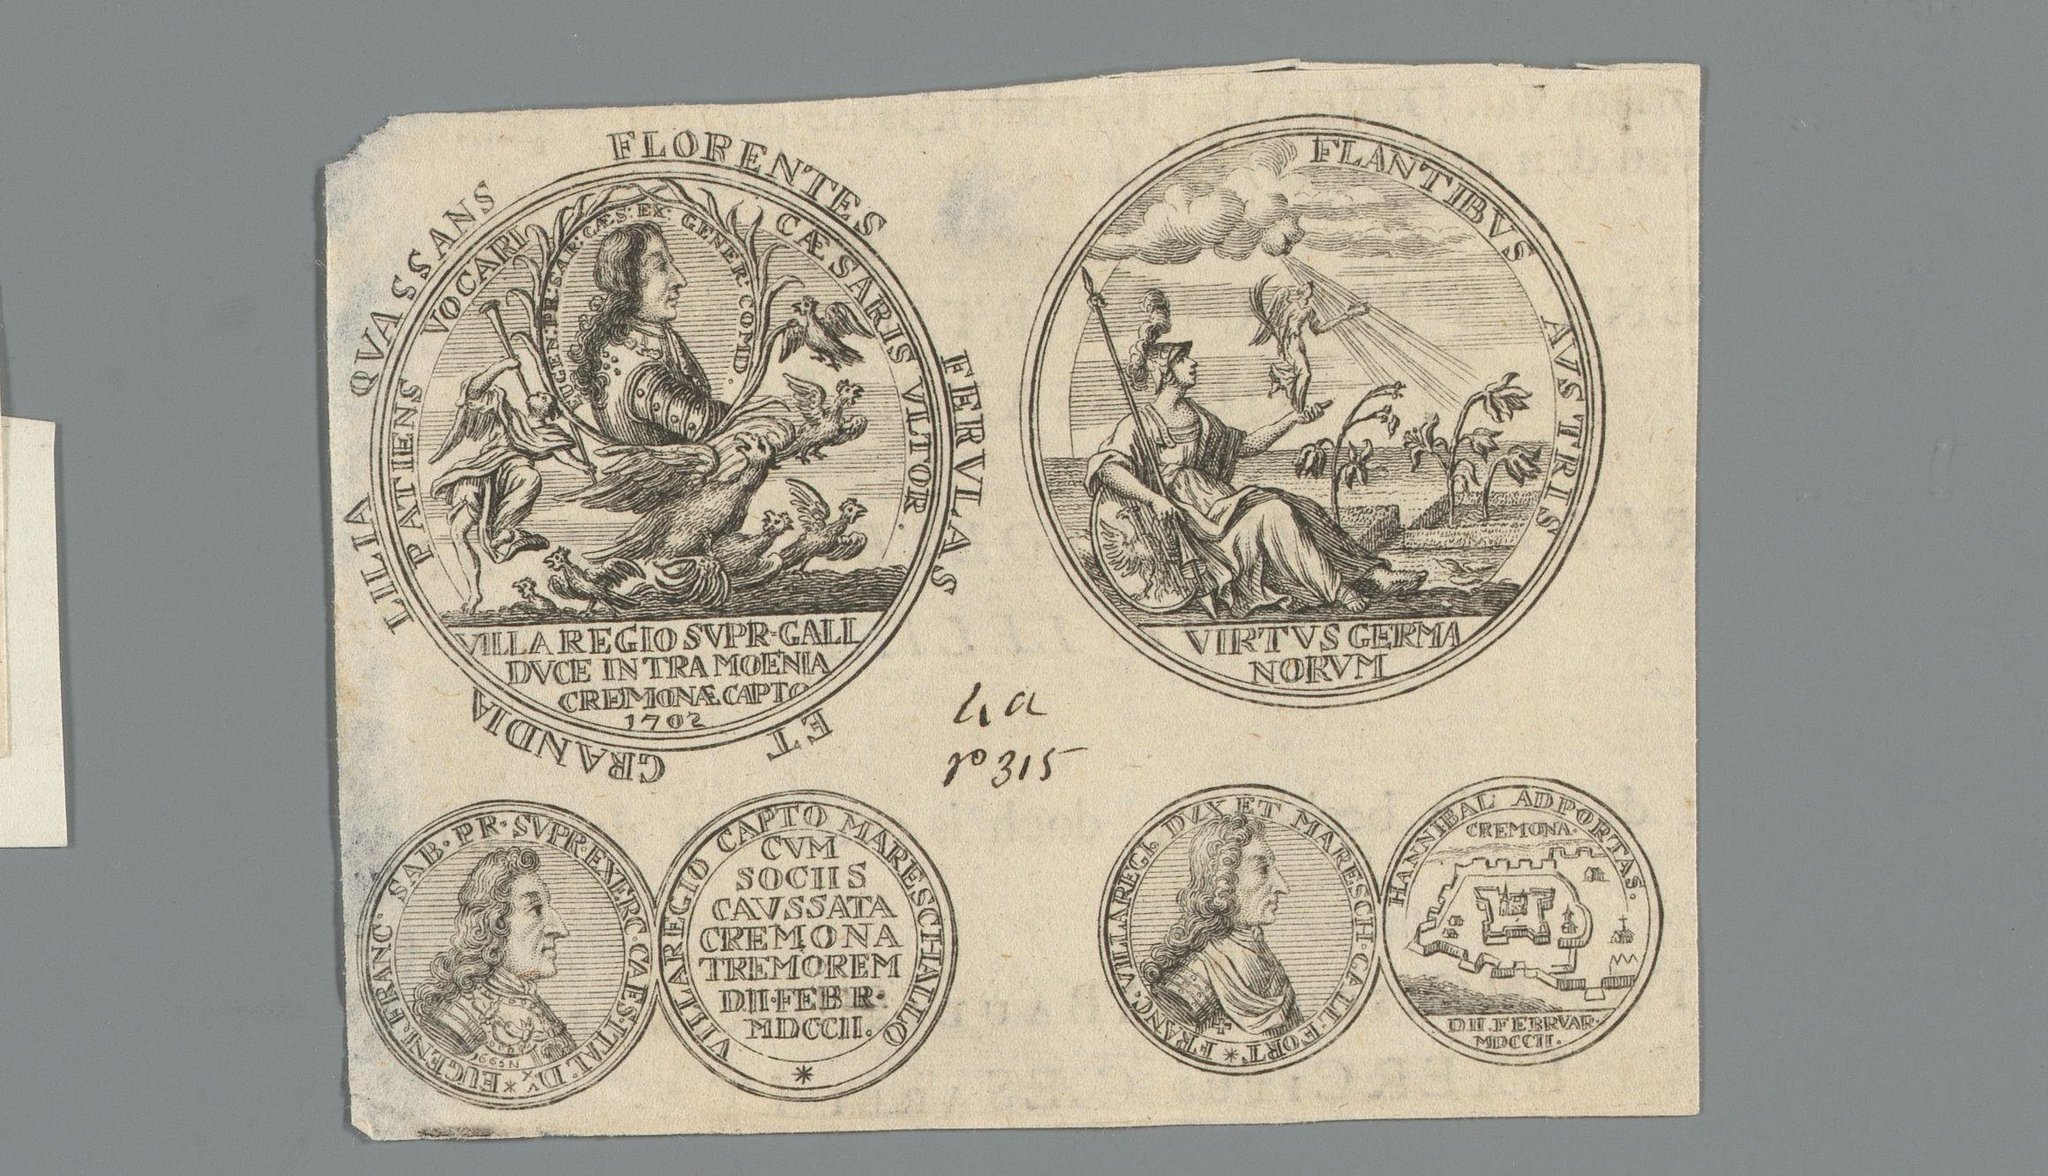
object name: print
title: Voor- en achterzijden van drie penningen met daarop de portretten van Eugenius van Savoye, een personificatie en de stad Cremona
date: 1731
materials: paper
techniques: etching, letterpress printing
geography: the hague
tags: paris, vienna, eugenius van savoye, fortress, commander-in-chief, general, marshal, historical persons, coin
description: Prent uit: Loon, Gerard van. Beschryving der Nederlandsche Historipenningen: (...). Den Haag: Christiaan van Lom et al., 1731, dl. 4, p. 315.